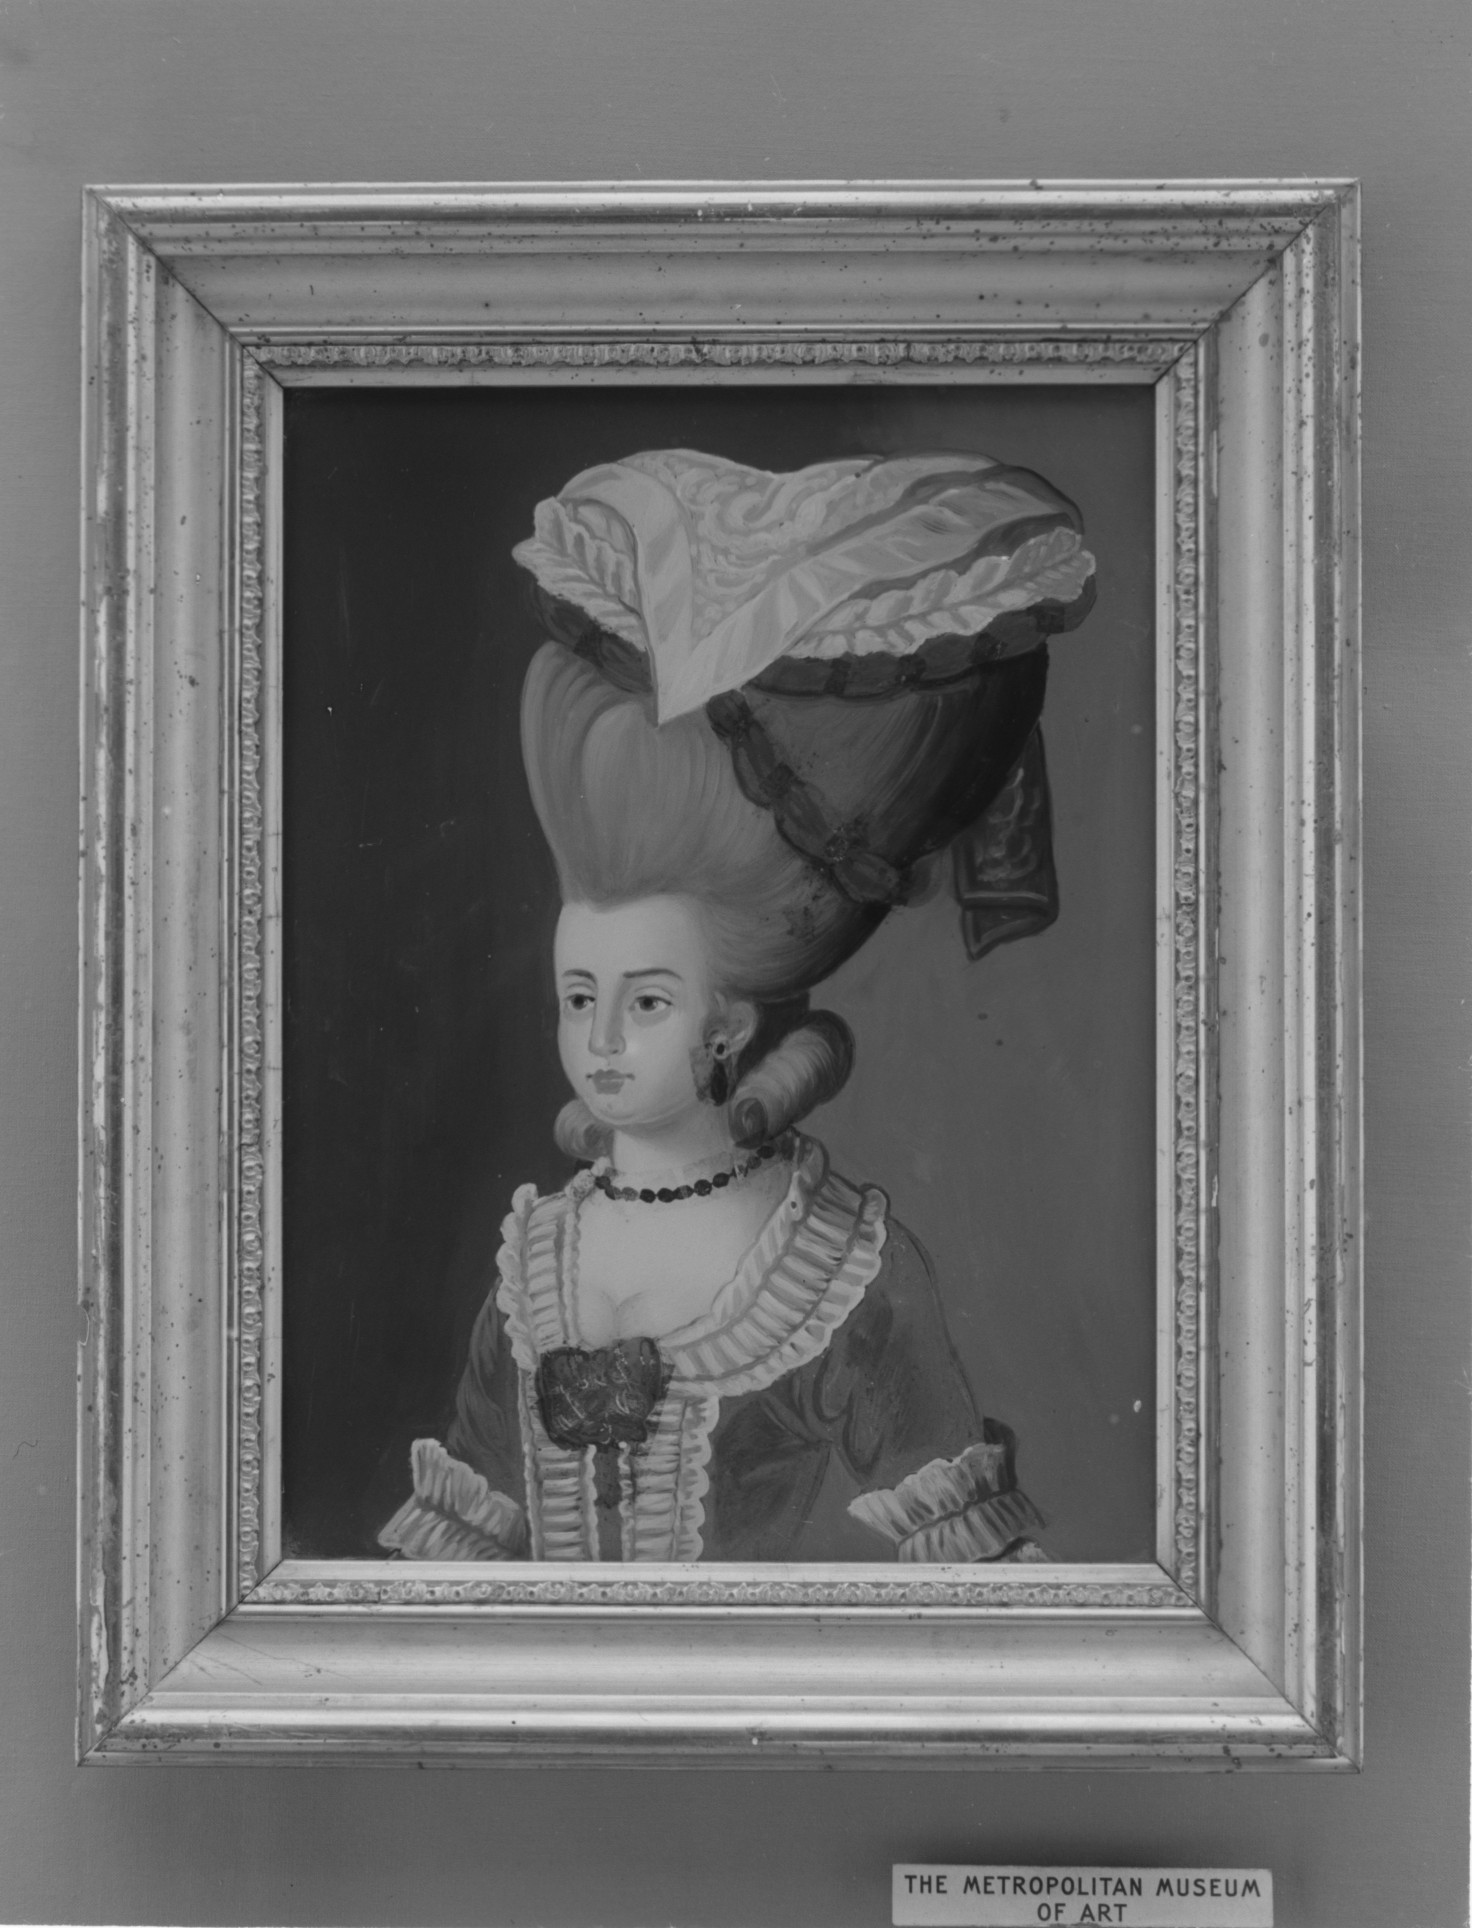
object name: portrait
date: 1780-1790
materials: glass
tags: portraits,women